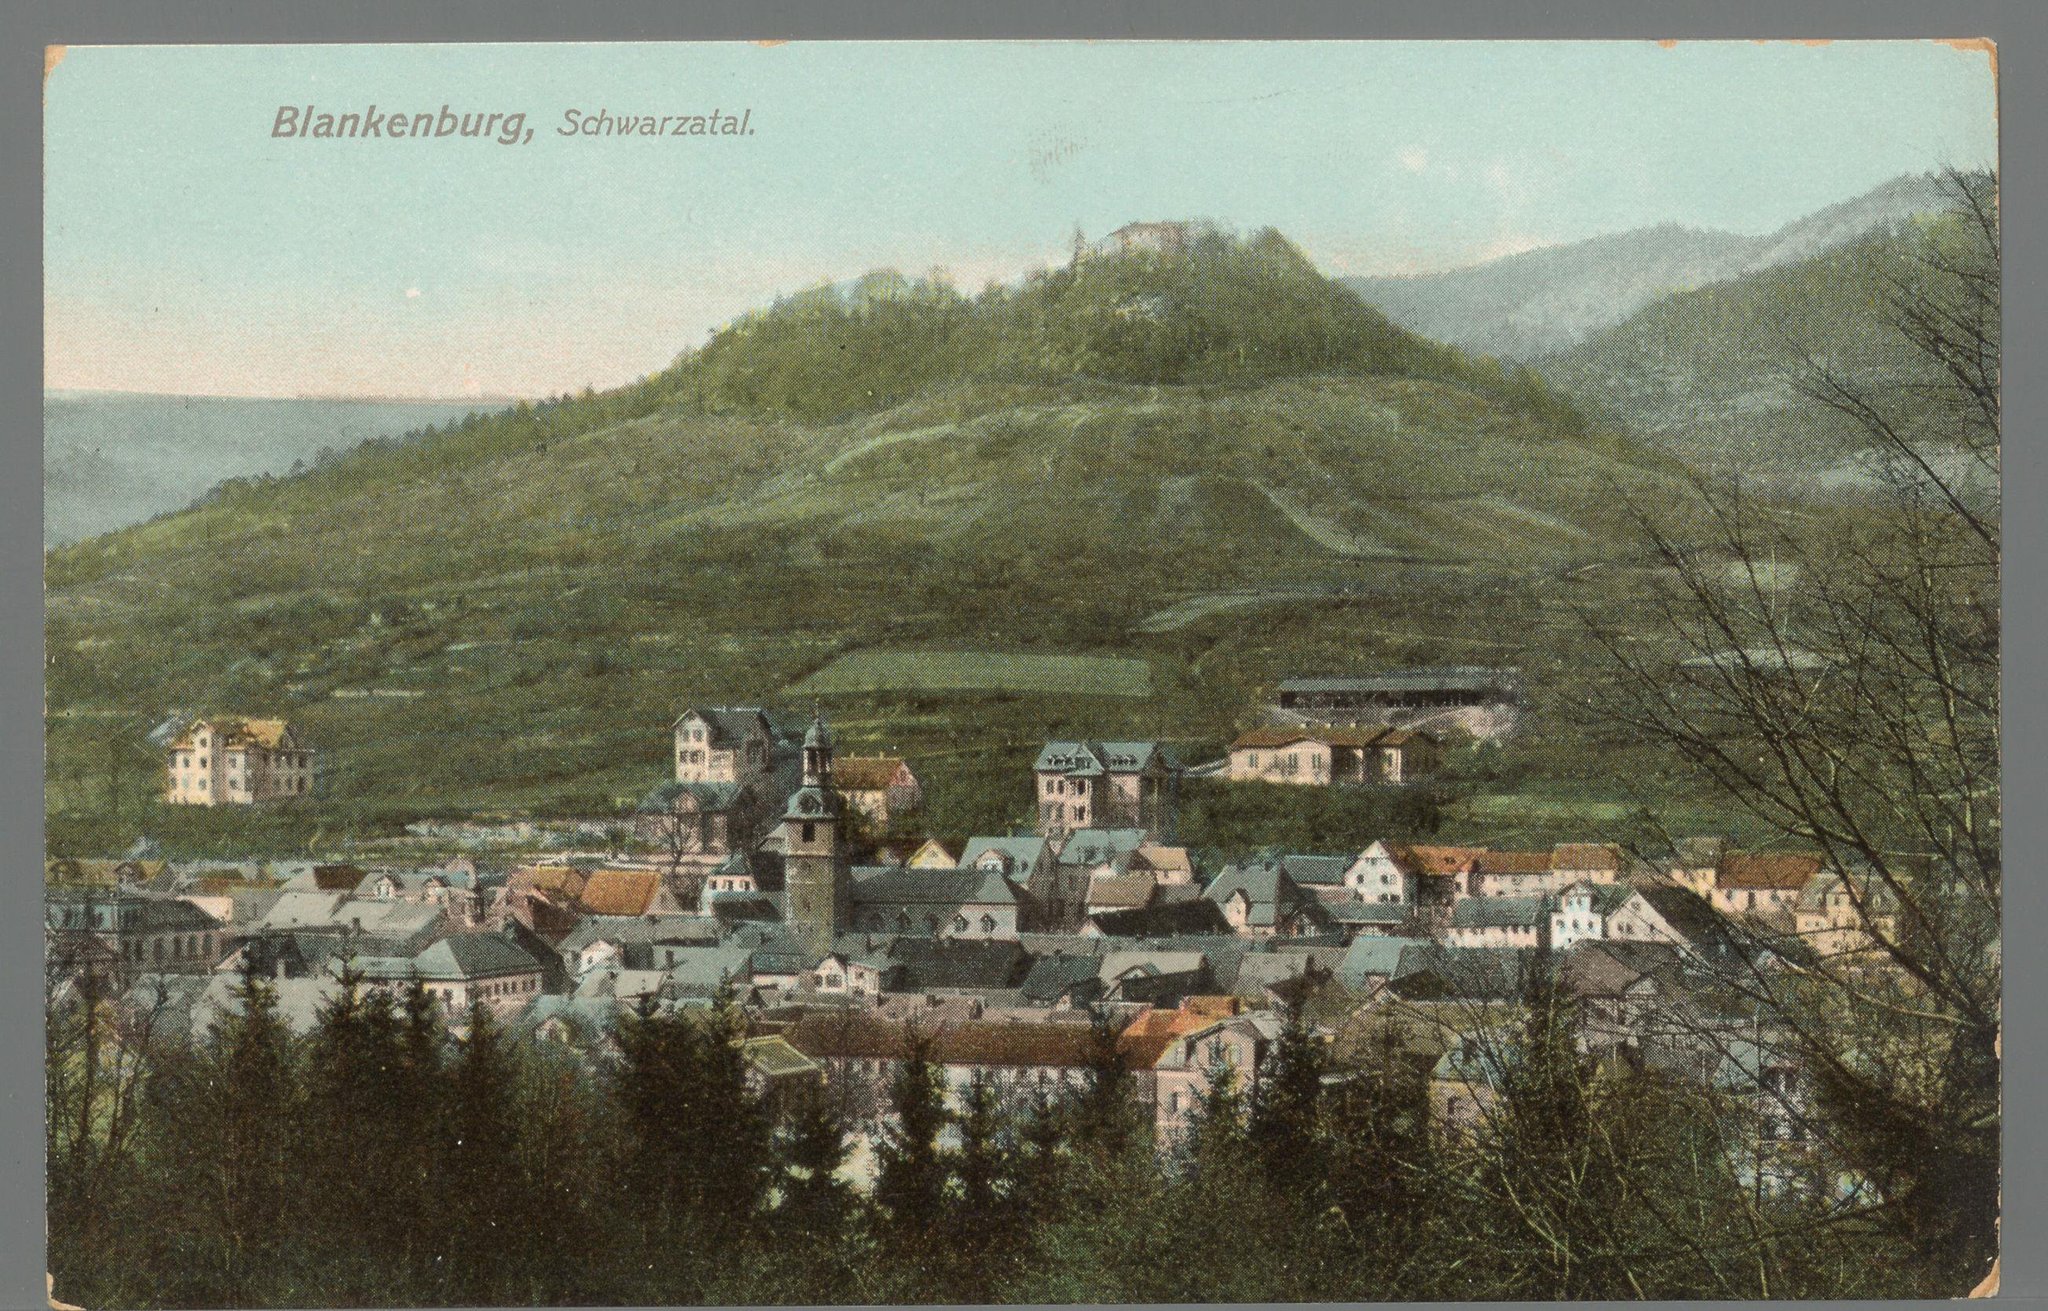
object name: photomechanical print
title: Blankenburg, Schwarzatal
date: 1905-1909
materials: cardboard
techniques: lithograph, writing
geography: blankenburg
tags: city-view, and landscape with man-made constructions, mountains